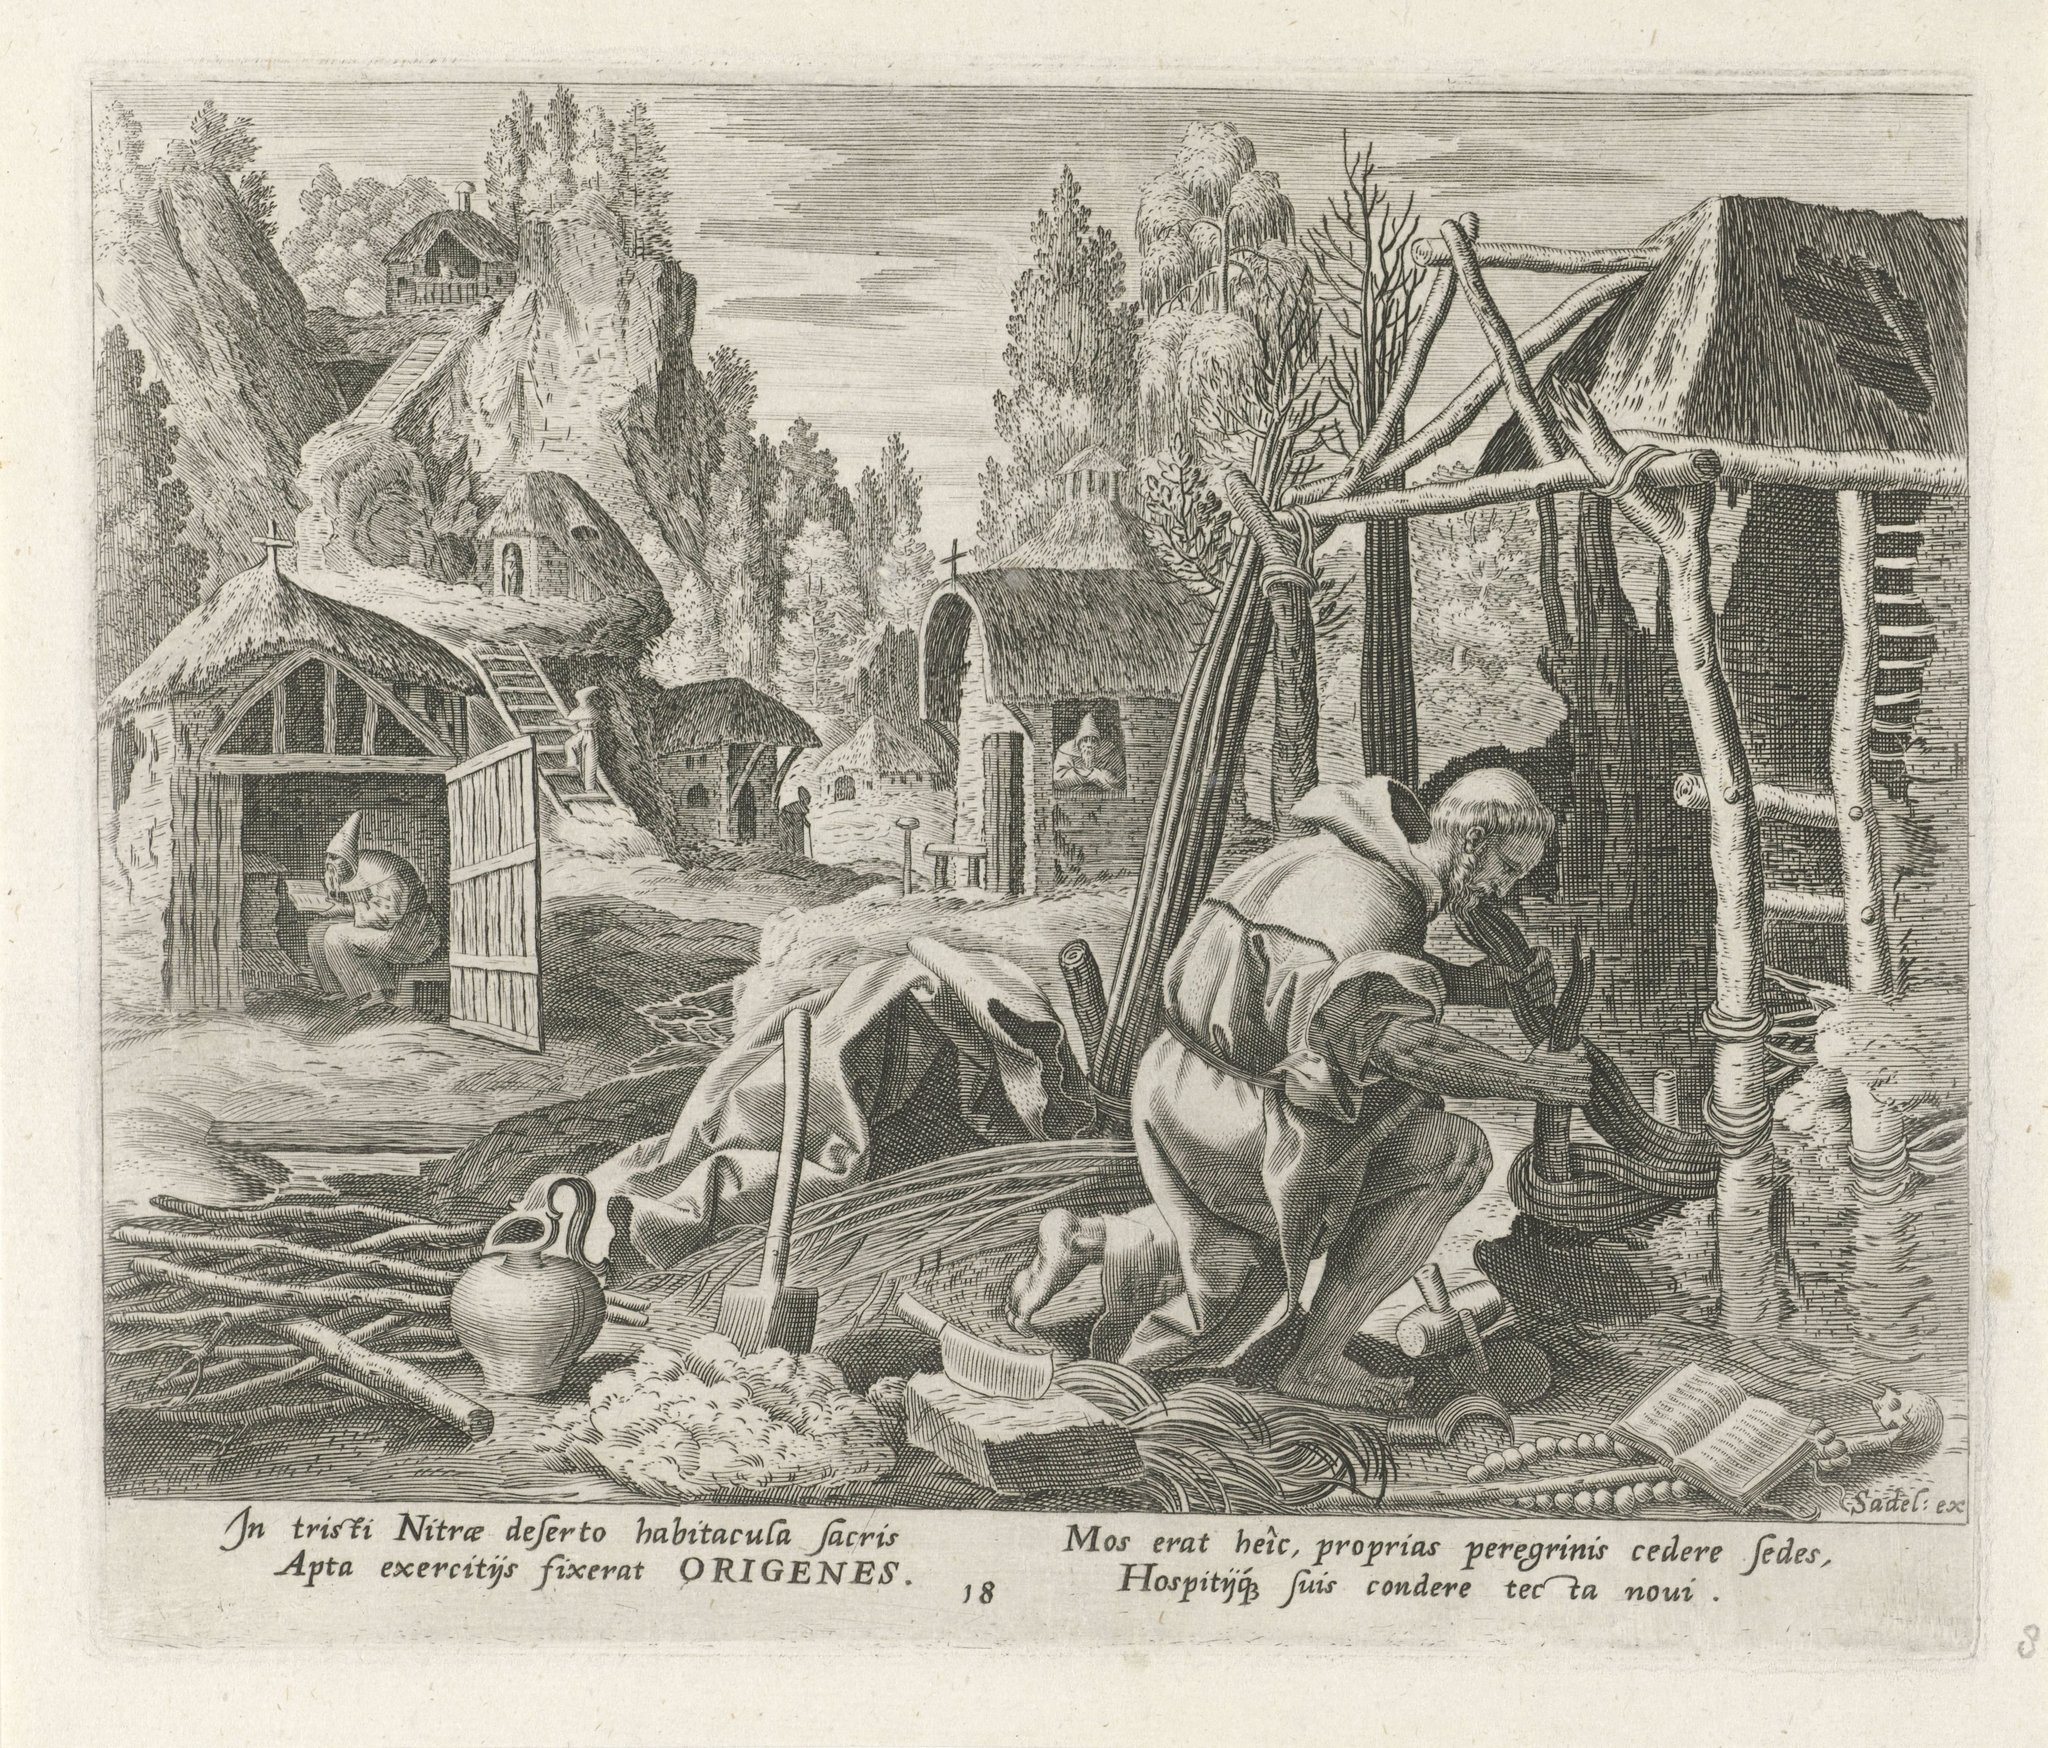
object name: print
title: Solitudo Sive Vitae Patrum Eremicolarum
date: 1583-1588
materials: paper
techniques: engraving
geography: antwerp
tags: withdrawal into the wilderness or desert ~ ascetic life, anchorite, hermit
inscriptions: collector's mark: Lugt 2228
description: Op de voorgrond een kluizenaar die een hut maakt in de woestijn van Nitra. Andere hutjes met kluizenaars op de achtergrond.